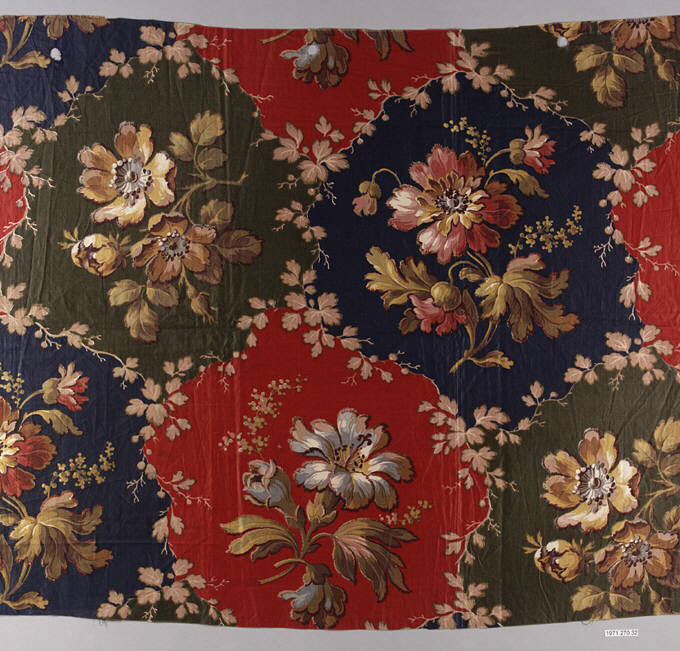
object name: piece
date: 1850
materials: cotton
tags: flowers,leaves